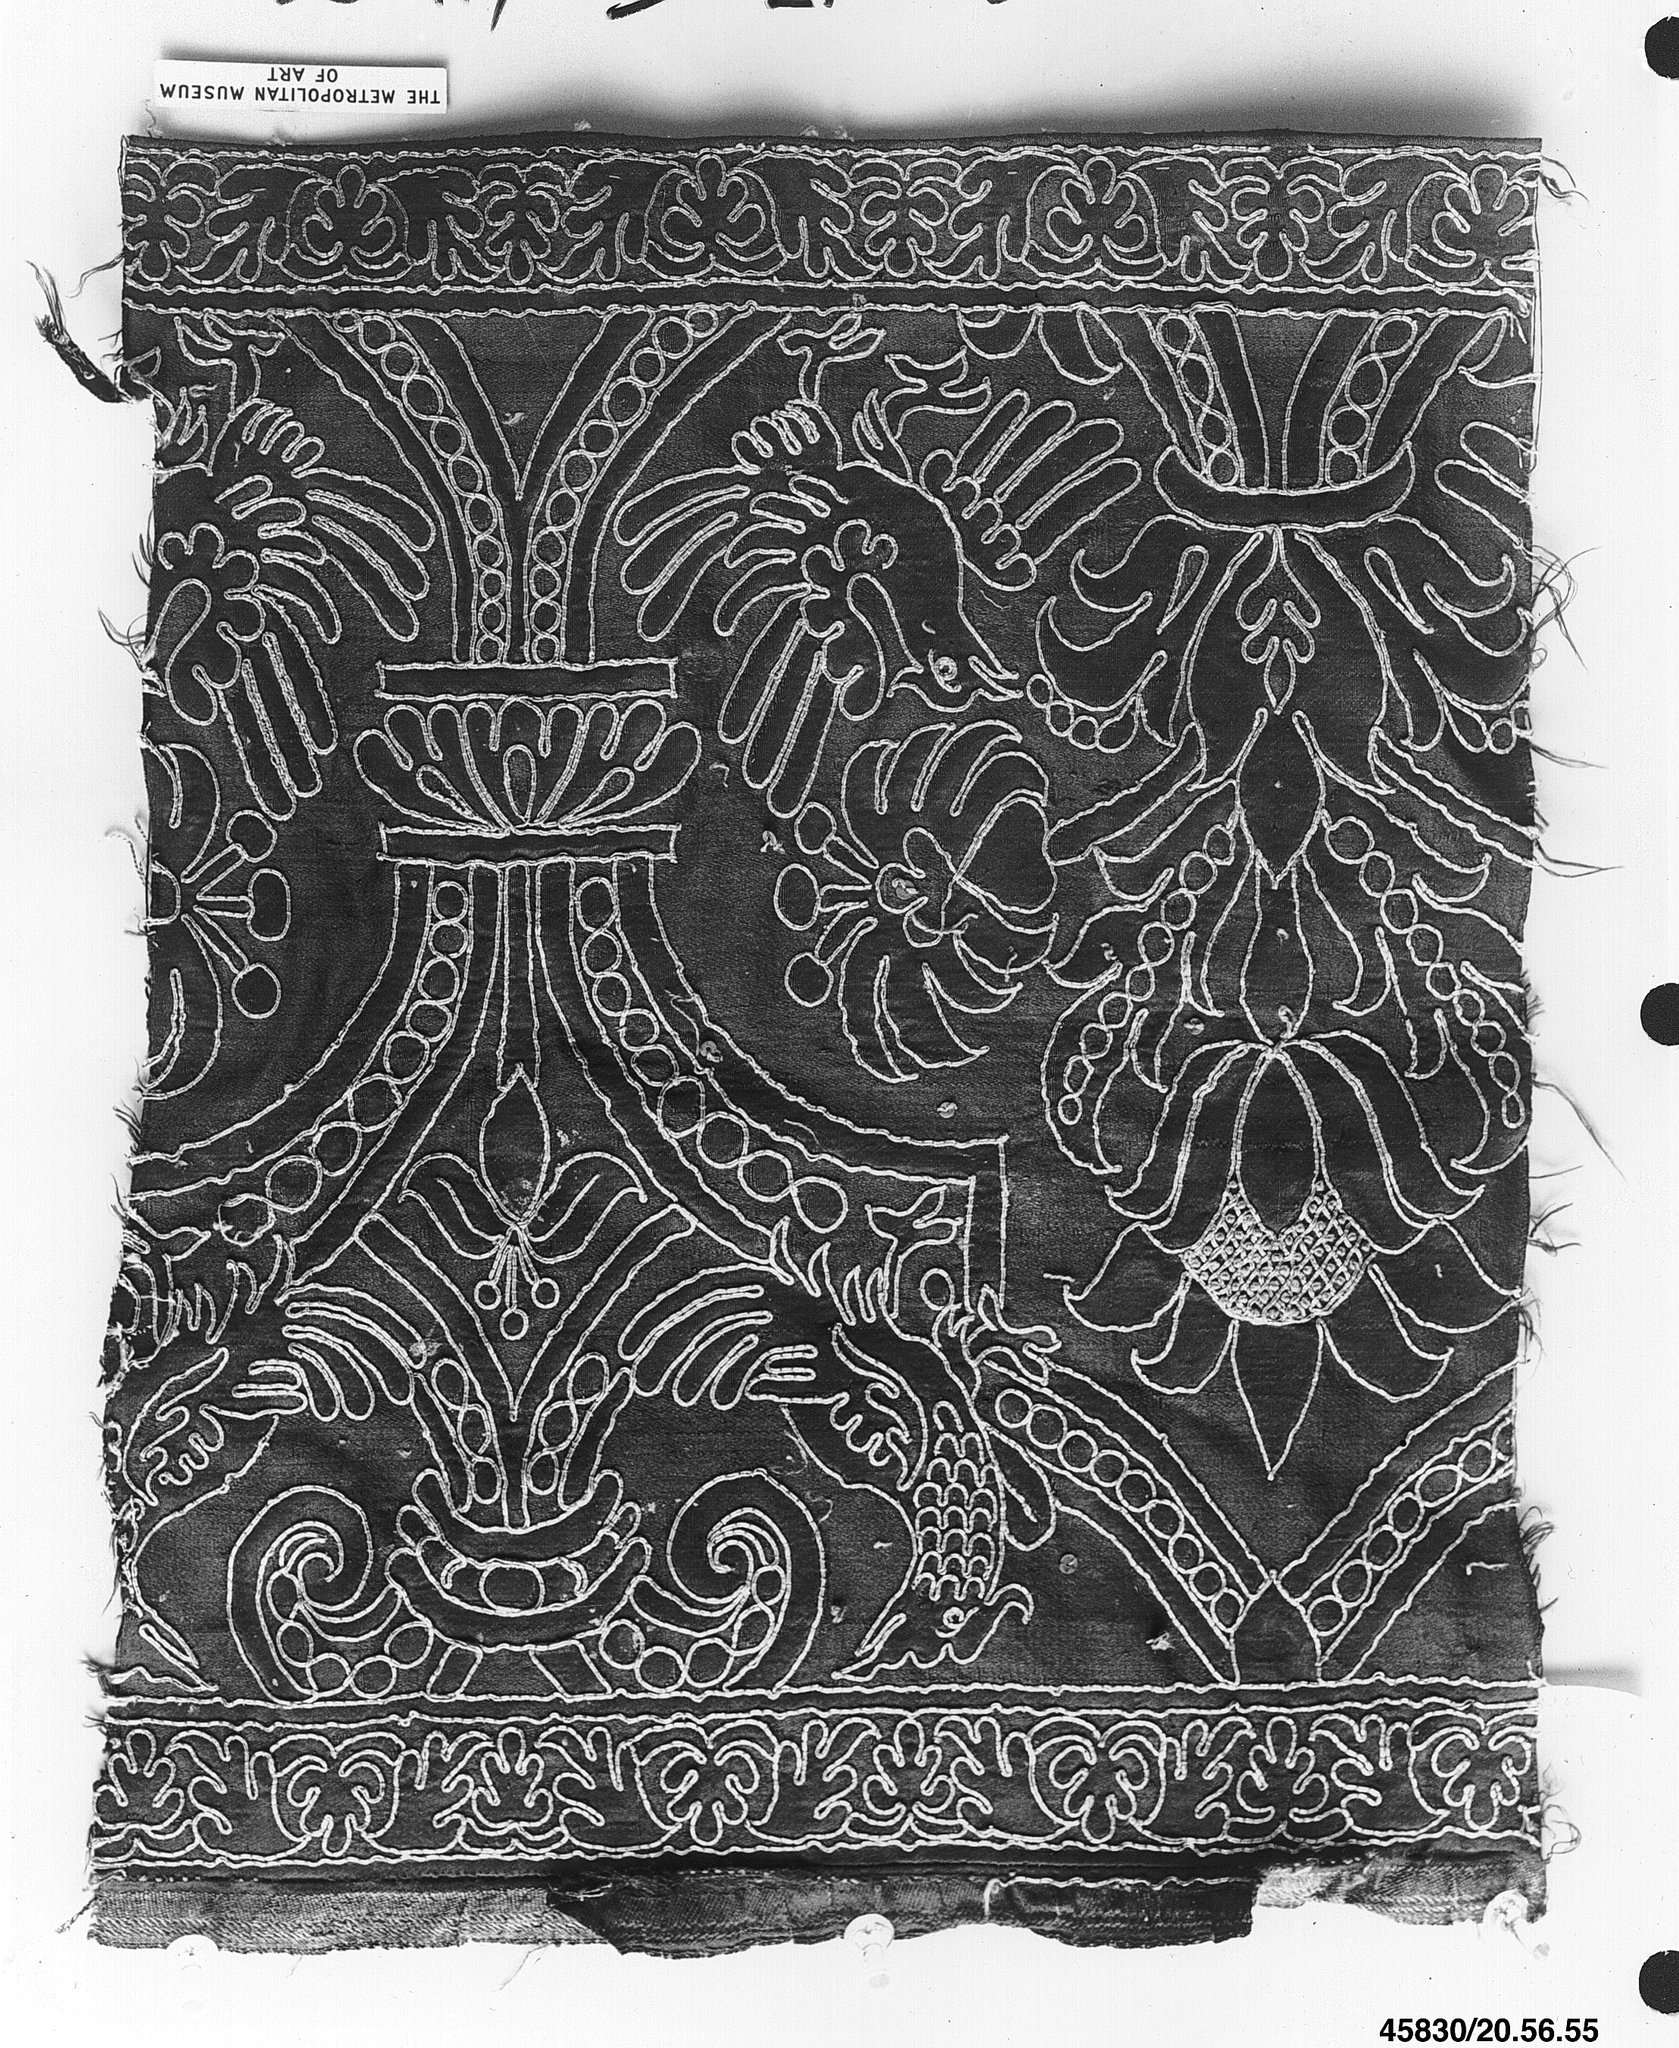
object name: piece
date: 1701-1800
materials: metal thread, silk